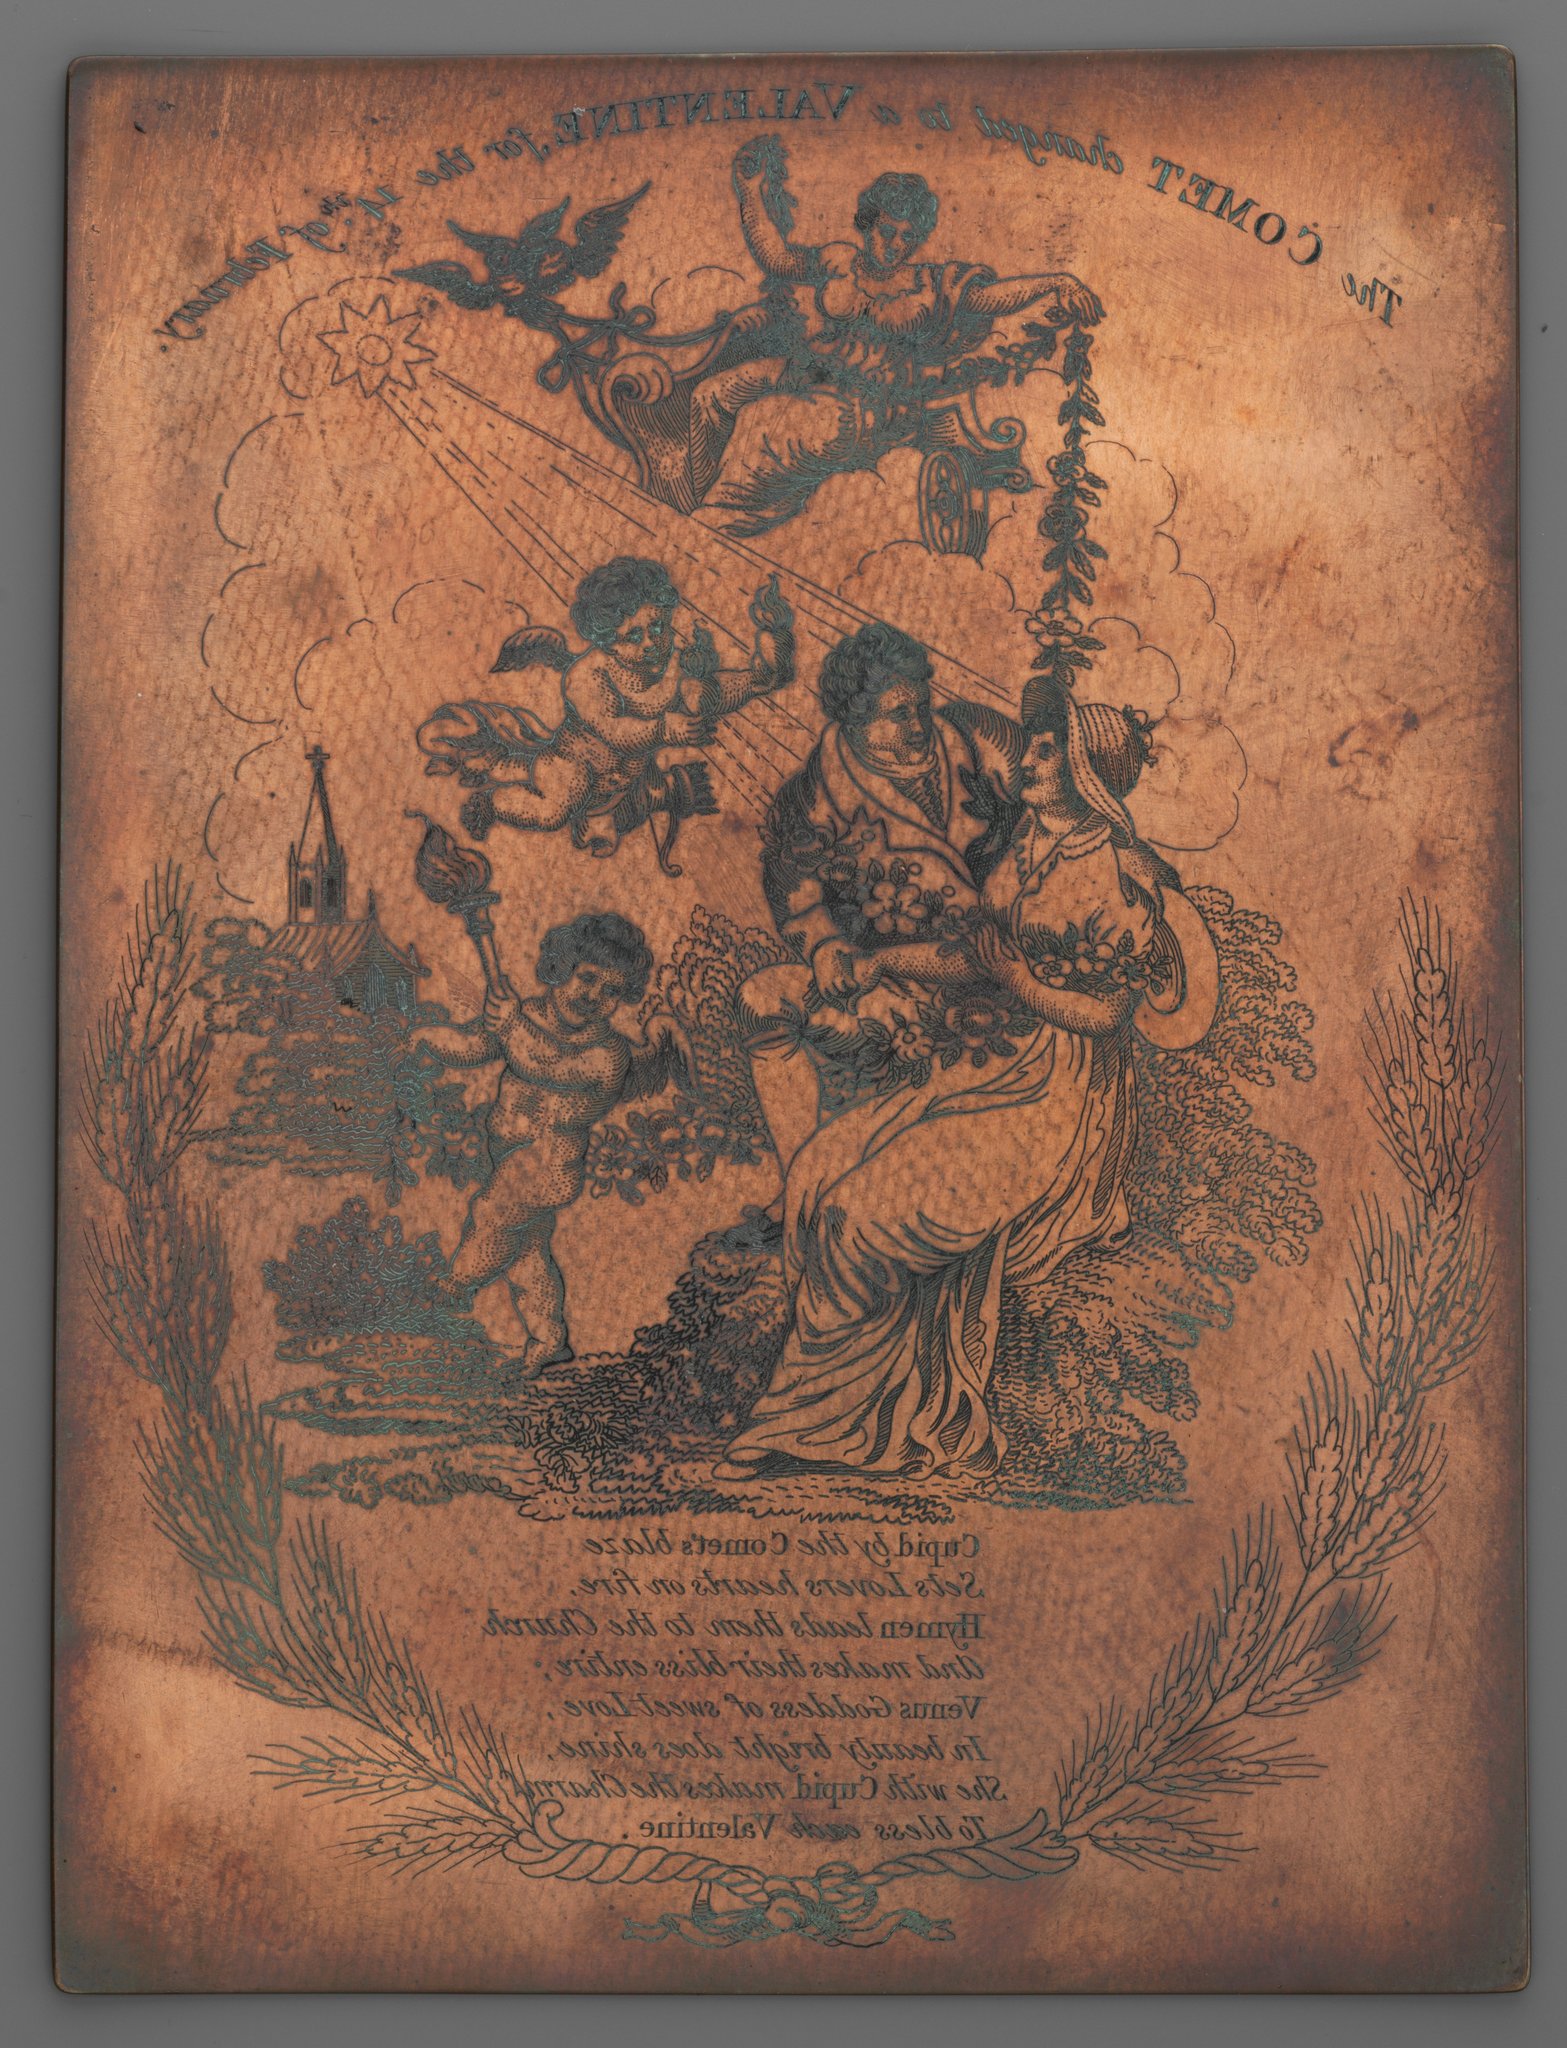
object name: etching plate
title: Etching plate for a Valentine in honor of Halley's Comet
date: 1835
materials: copper, ink